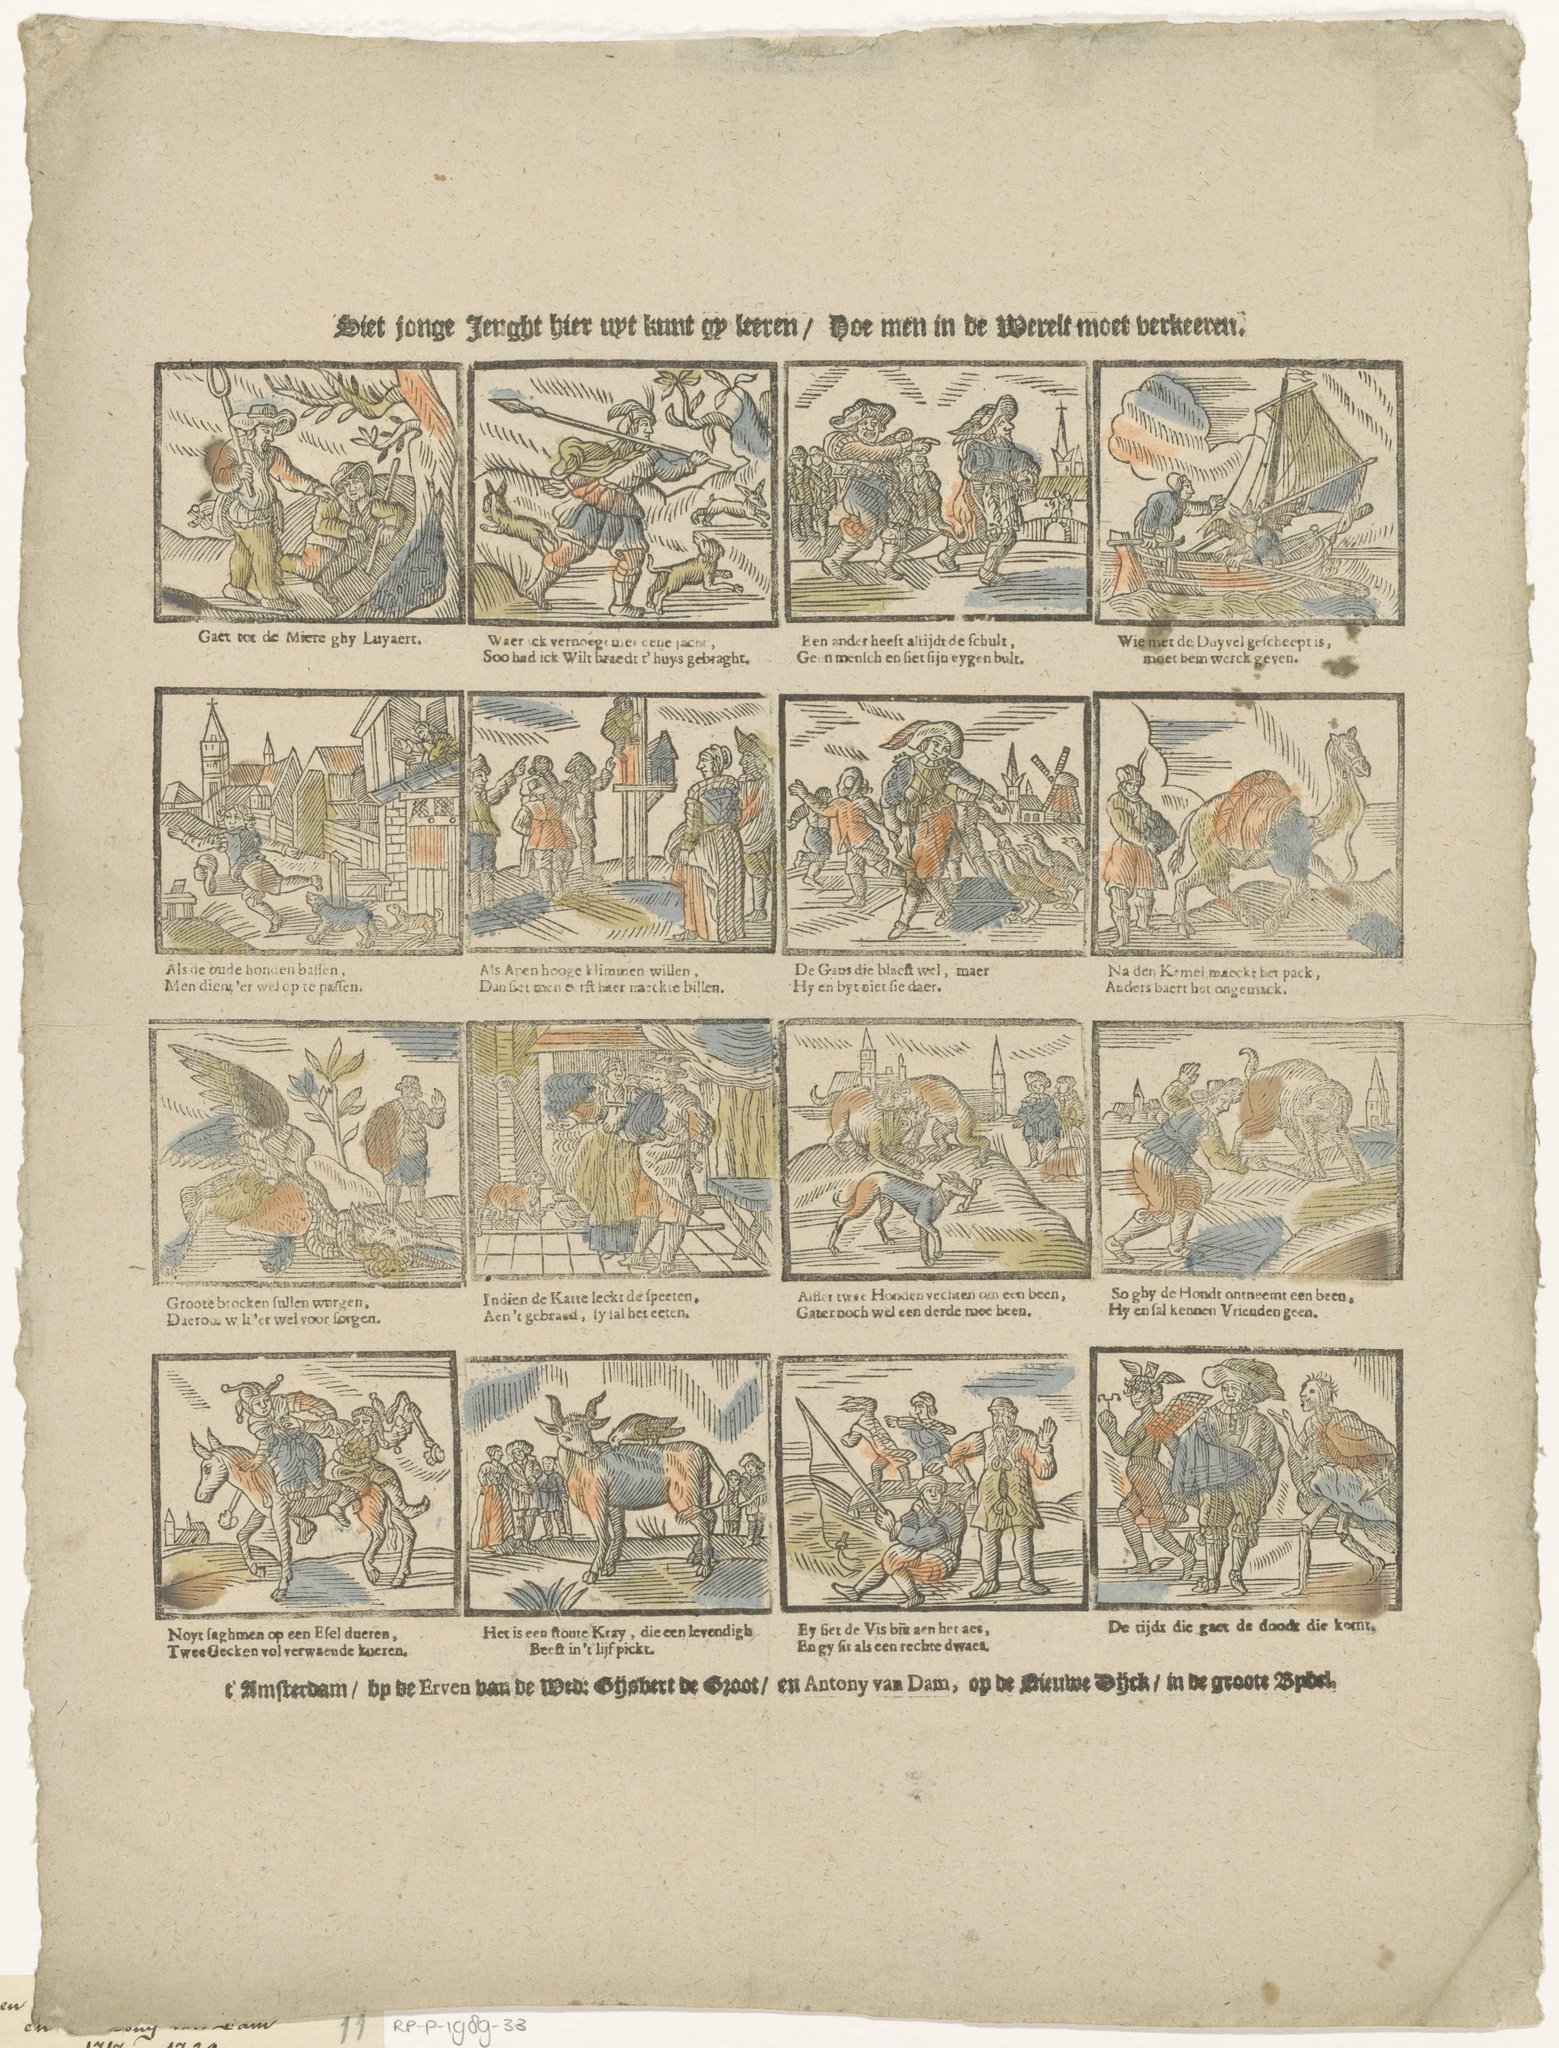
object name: print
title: Siet jonge jeught hier uyt kunt gy leeren / Hoe men in de werelt moet verkeeren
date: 1719-1724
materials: paper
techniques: colour, letterpress printing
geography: amsterdam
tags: proverbs, sayings, etc.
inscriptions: collector's mark: Lugt 2760, collector's mark: Lugt 2228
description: Blad met 16 verbeeldingen van spreekwoorden. Onder elke afbeelding een tweeregelig vers.